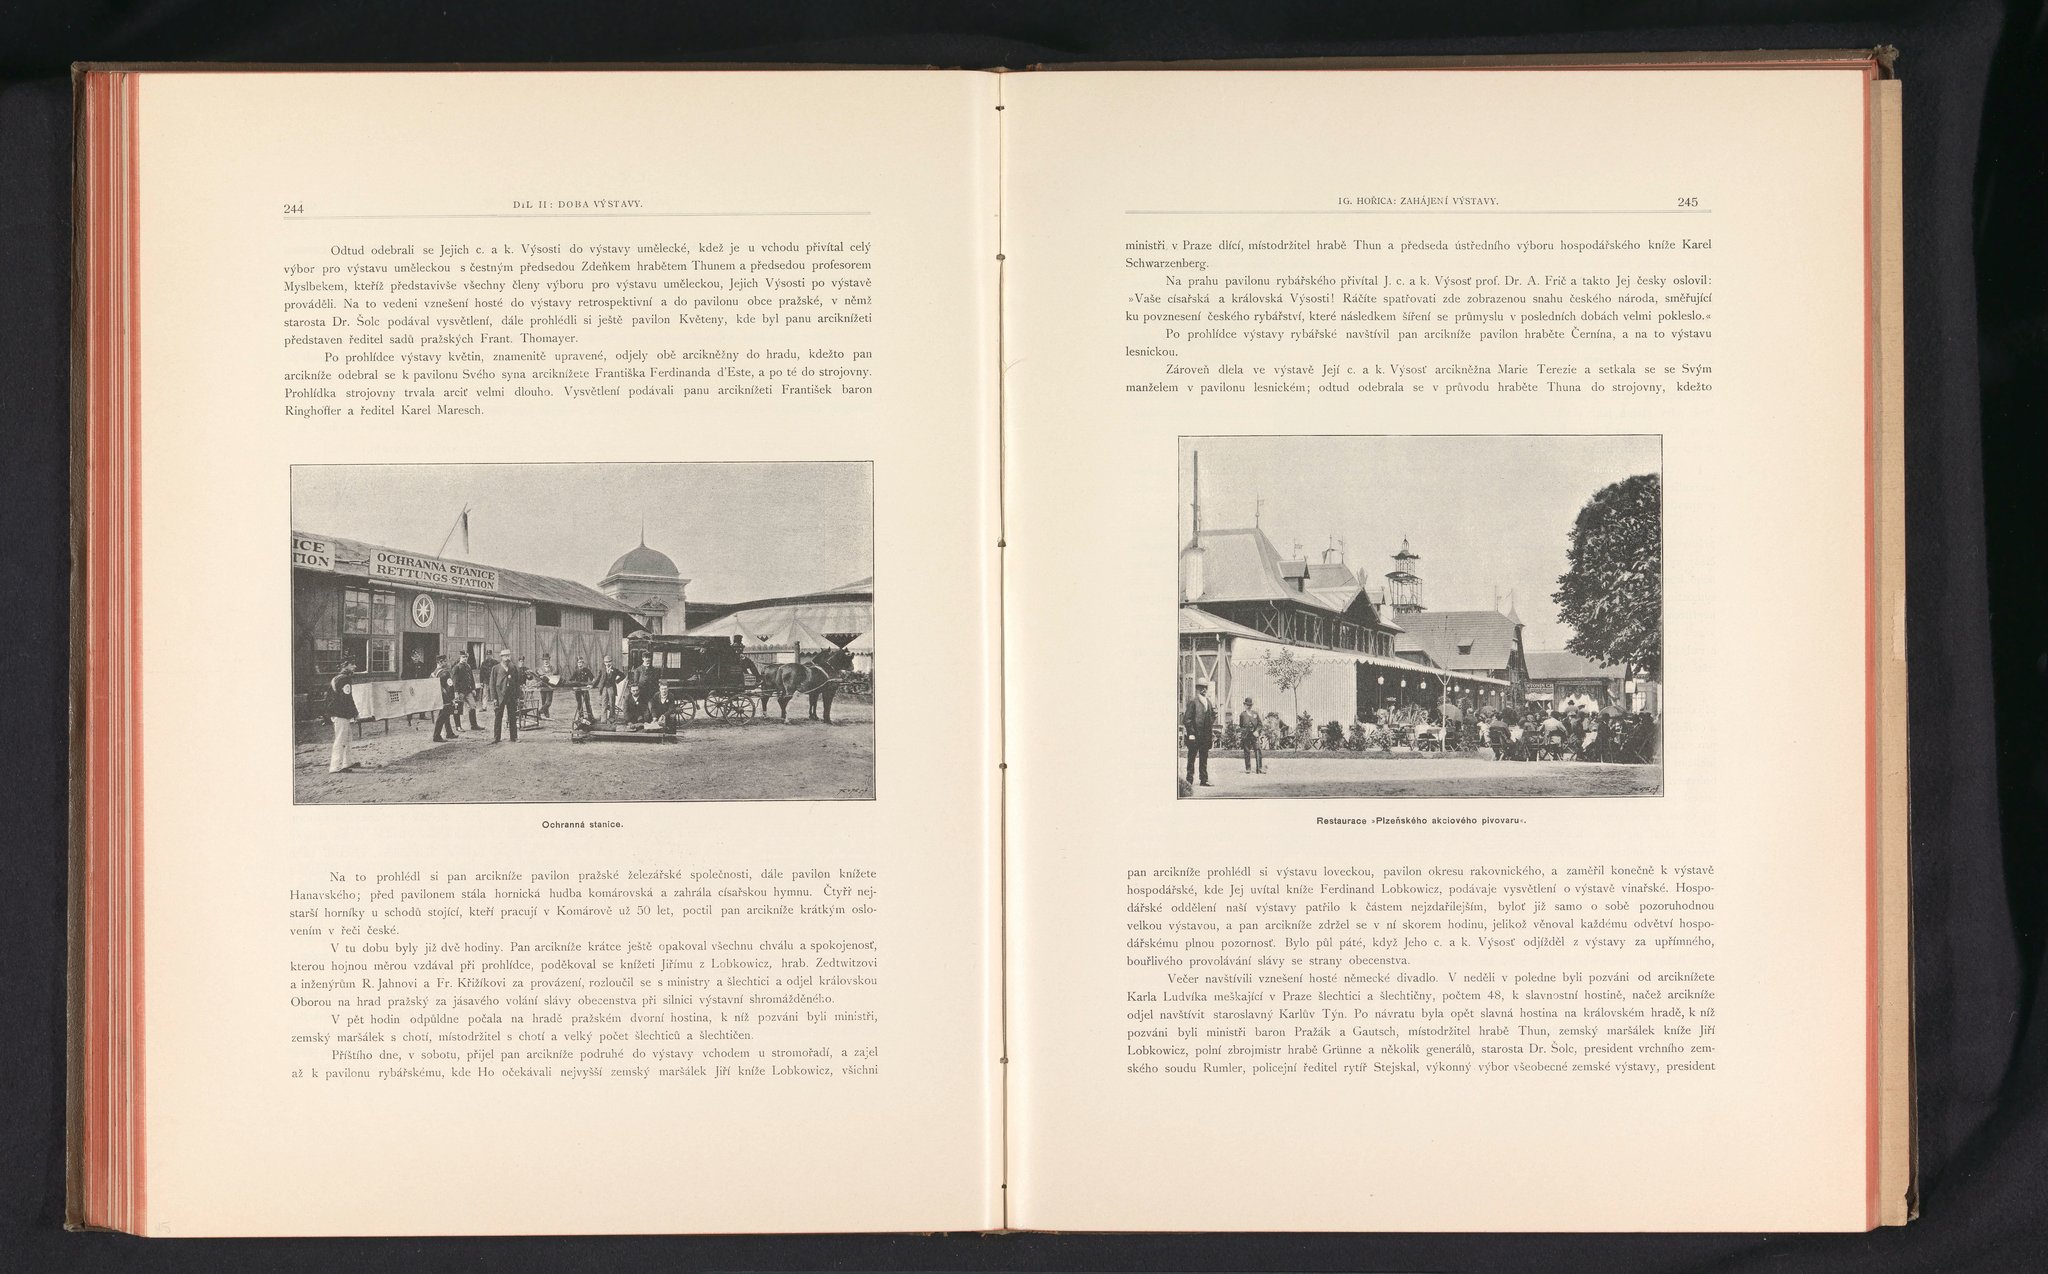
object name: page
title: Restaurace ,,Plzenského akciového pivovaru"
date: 1891-1893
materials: paper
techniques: autotype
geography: prague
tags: restaurant